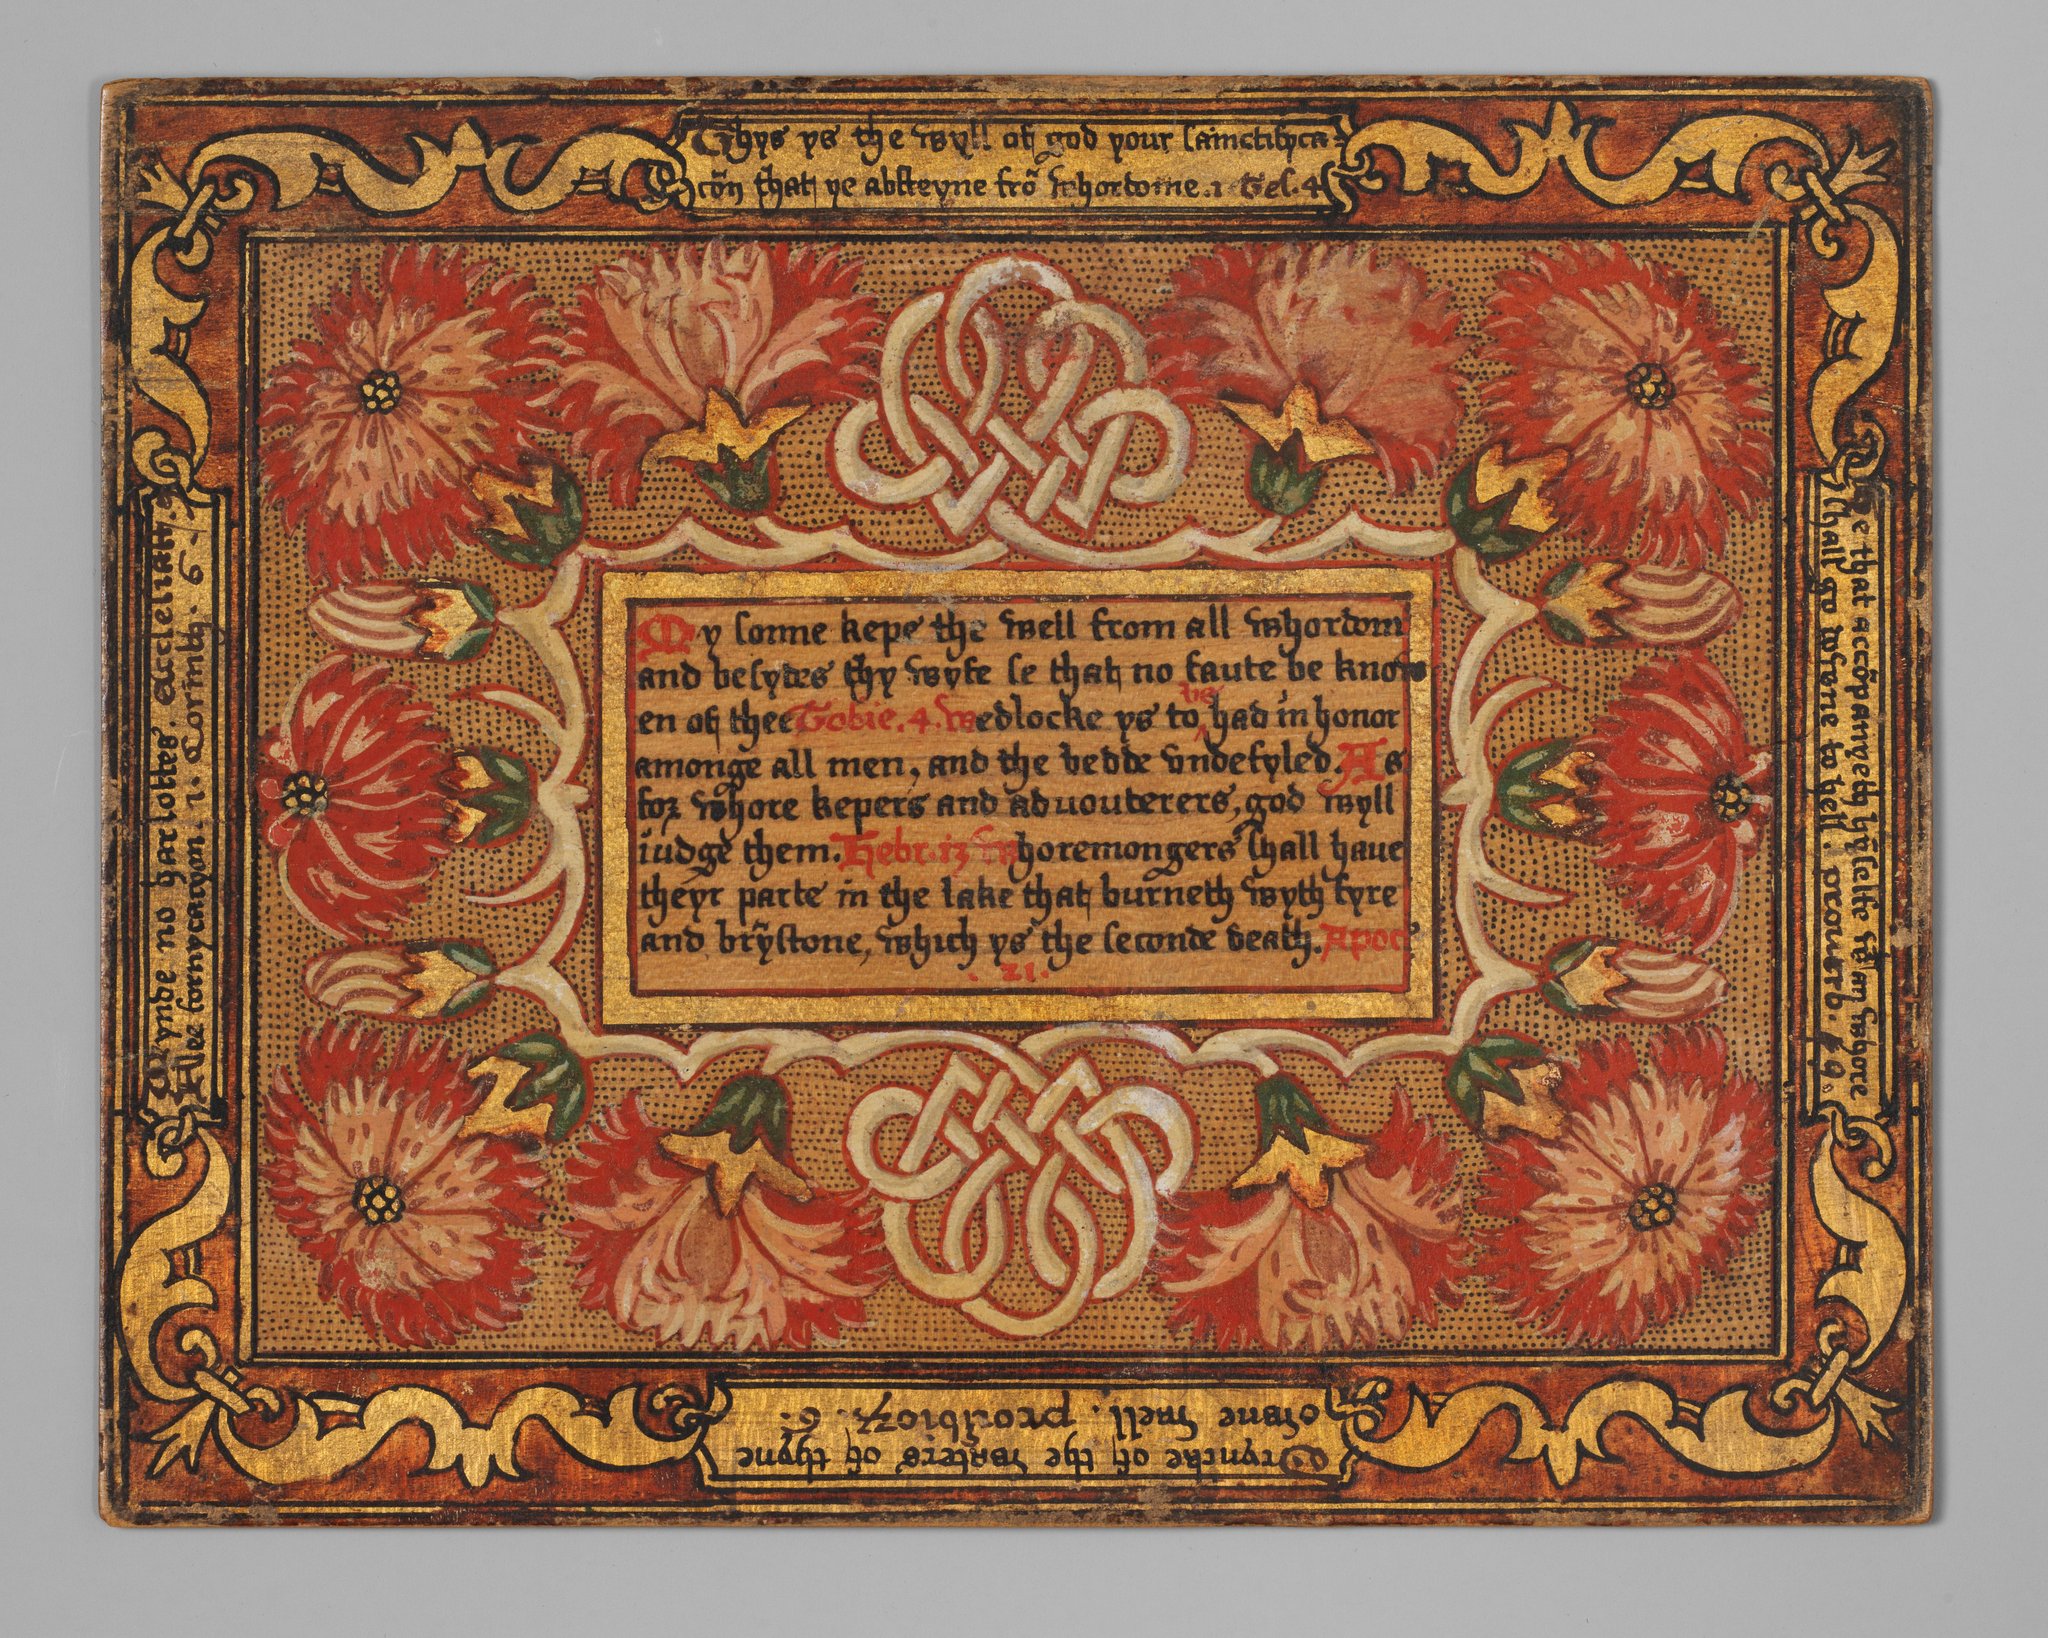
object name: trencher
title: Trencher with quotation from The Governance of Virtue (1566) (one of a set)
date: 1601-1633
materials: wood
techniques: gilding, painting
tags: flowers